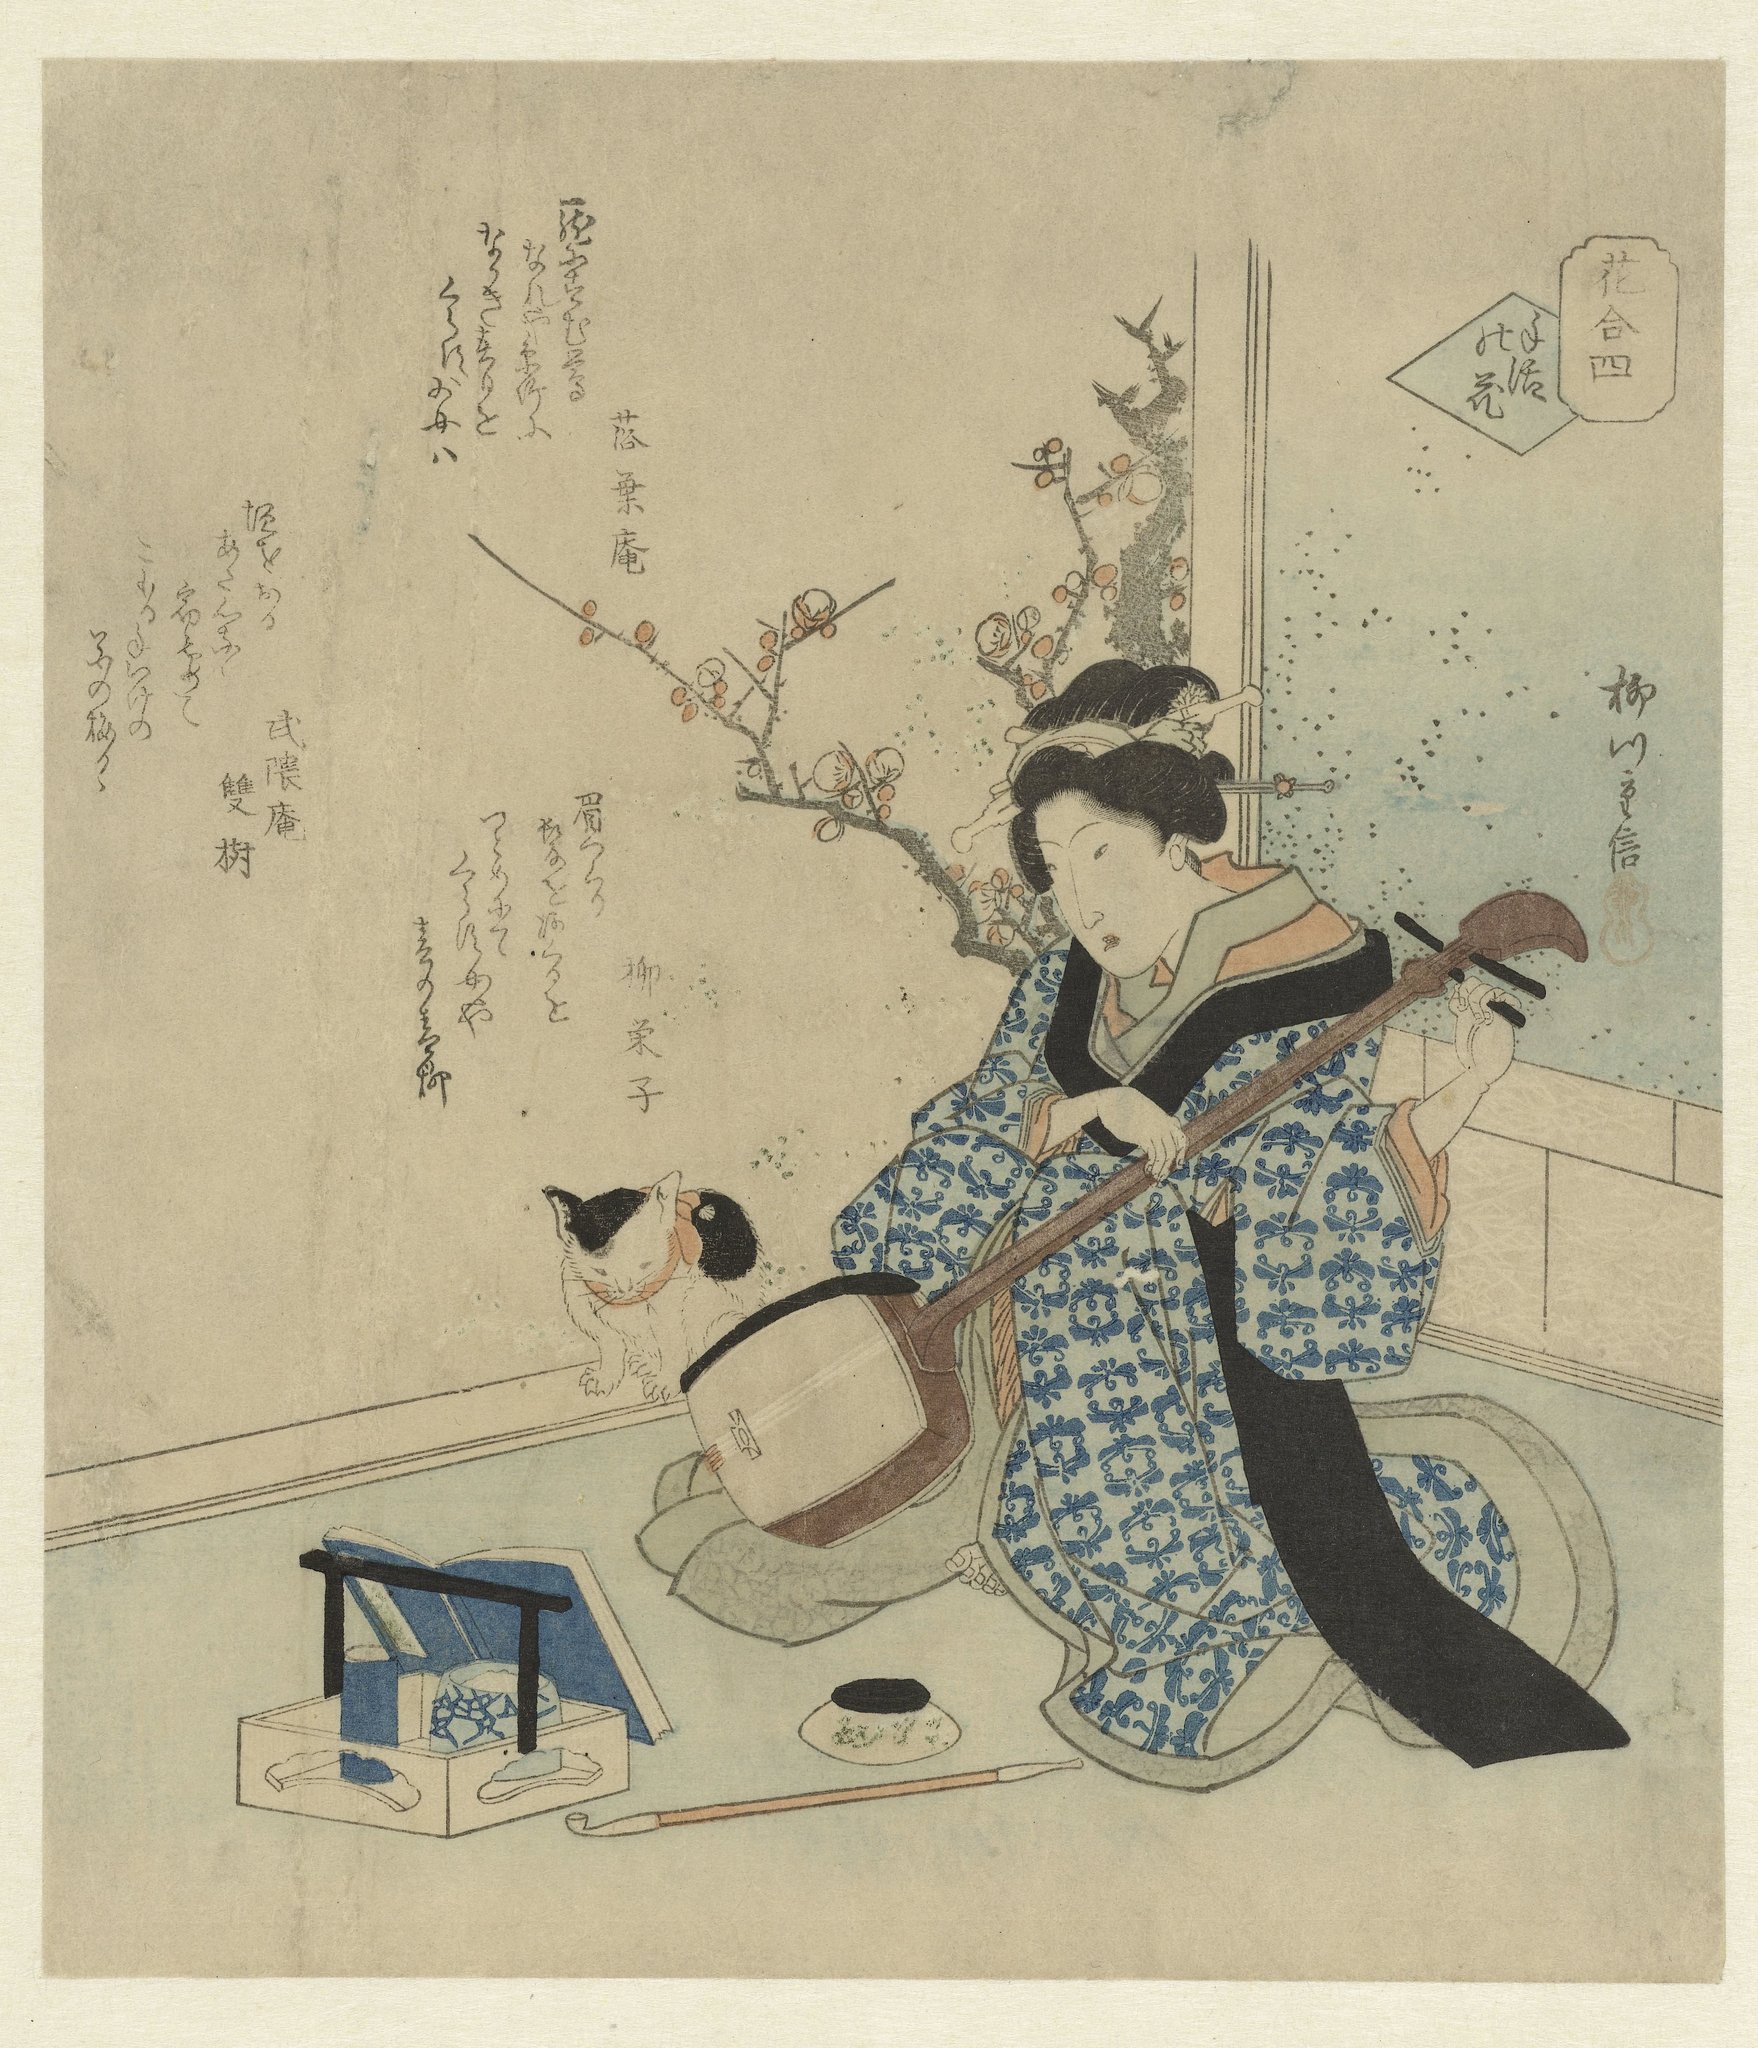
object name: surimono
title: Geisha Tuning her Shamisen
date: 1825-1830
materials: paper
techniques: blind stamped, woodcut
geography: japan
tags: cat, courtesan, hetaera, string instruments (plucked)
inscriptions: inscription, verso, handwritten: Japanese character for number 10.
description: Een surimono is een luxe uitgevoerde prent waarop beeld met één of meerdere gedichten gecombineerd is. Bij het drukken van een surimono werd vaak gebruik gemaakt van dikker papier, blinddruk en metaal pigmenten, zoals koper- en zilverpoeder. De prenten werden vaak in opdracht van dichters gemaakt en als exclusief geschenk aan vrienden en relaties gegeven.